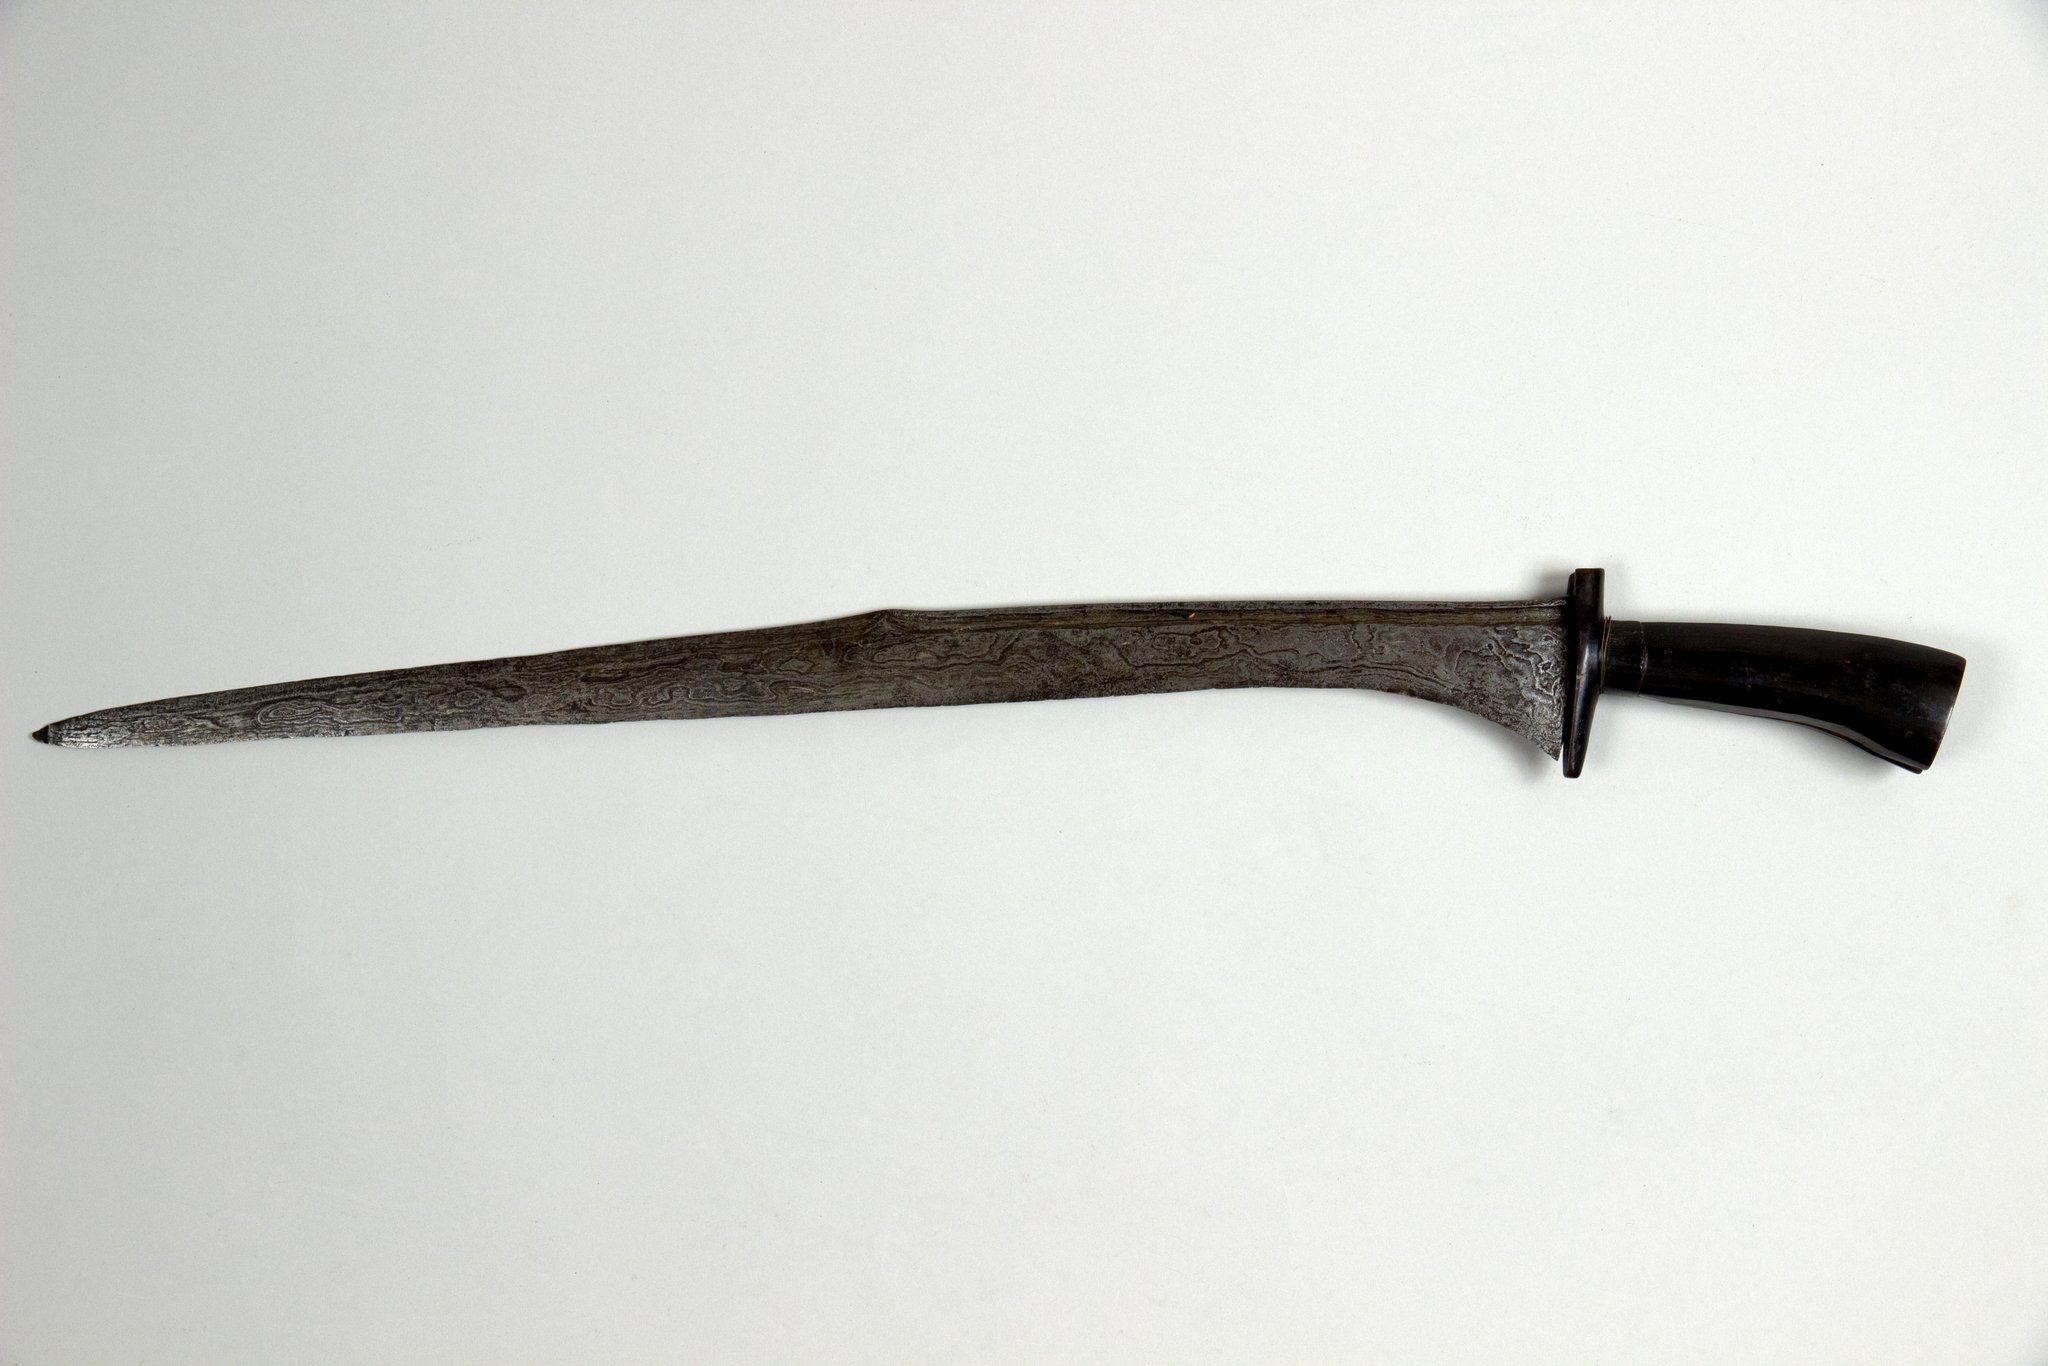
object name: saber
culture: javanese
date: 1501-1900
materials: horn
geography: indonesia